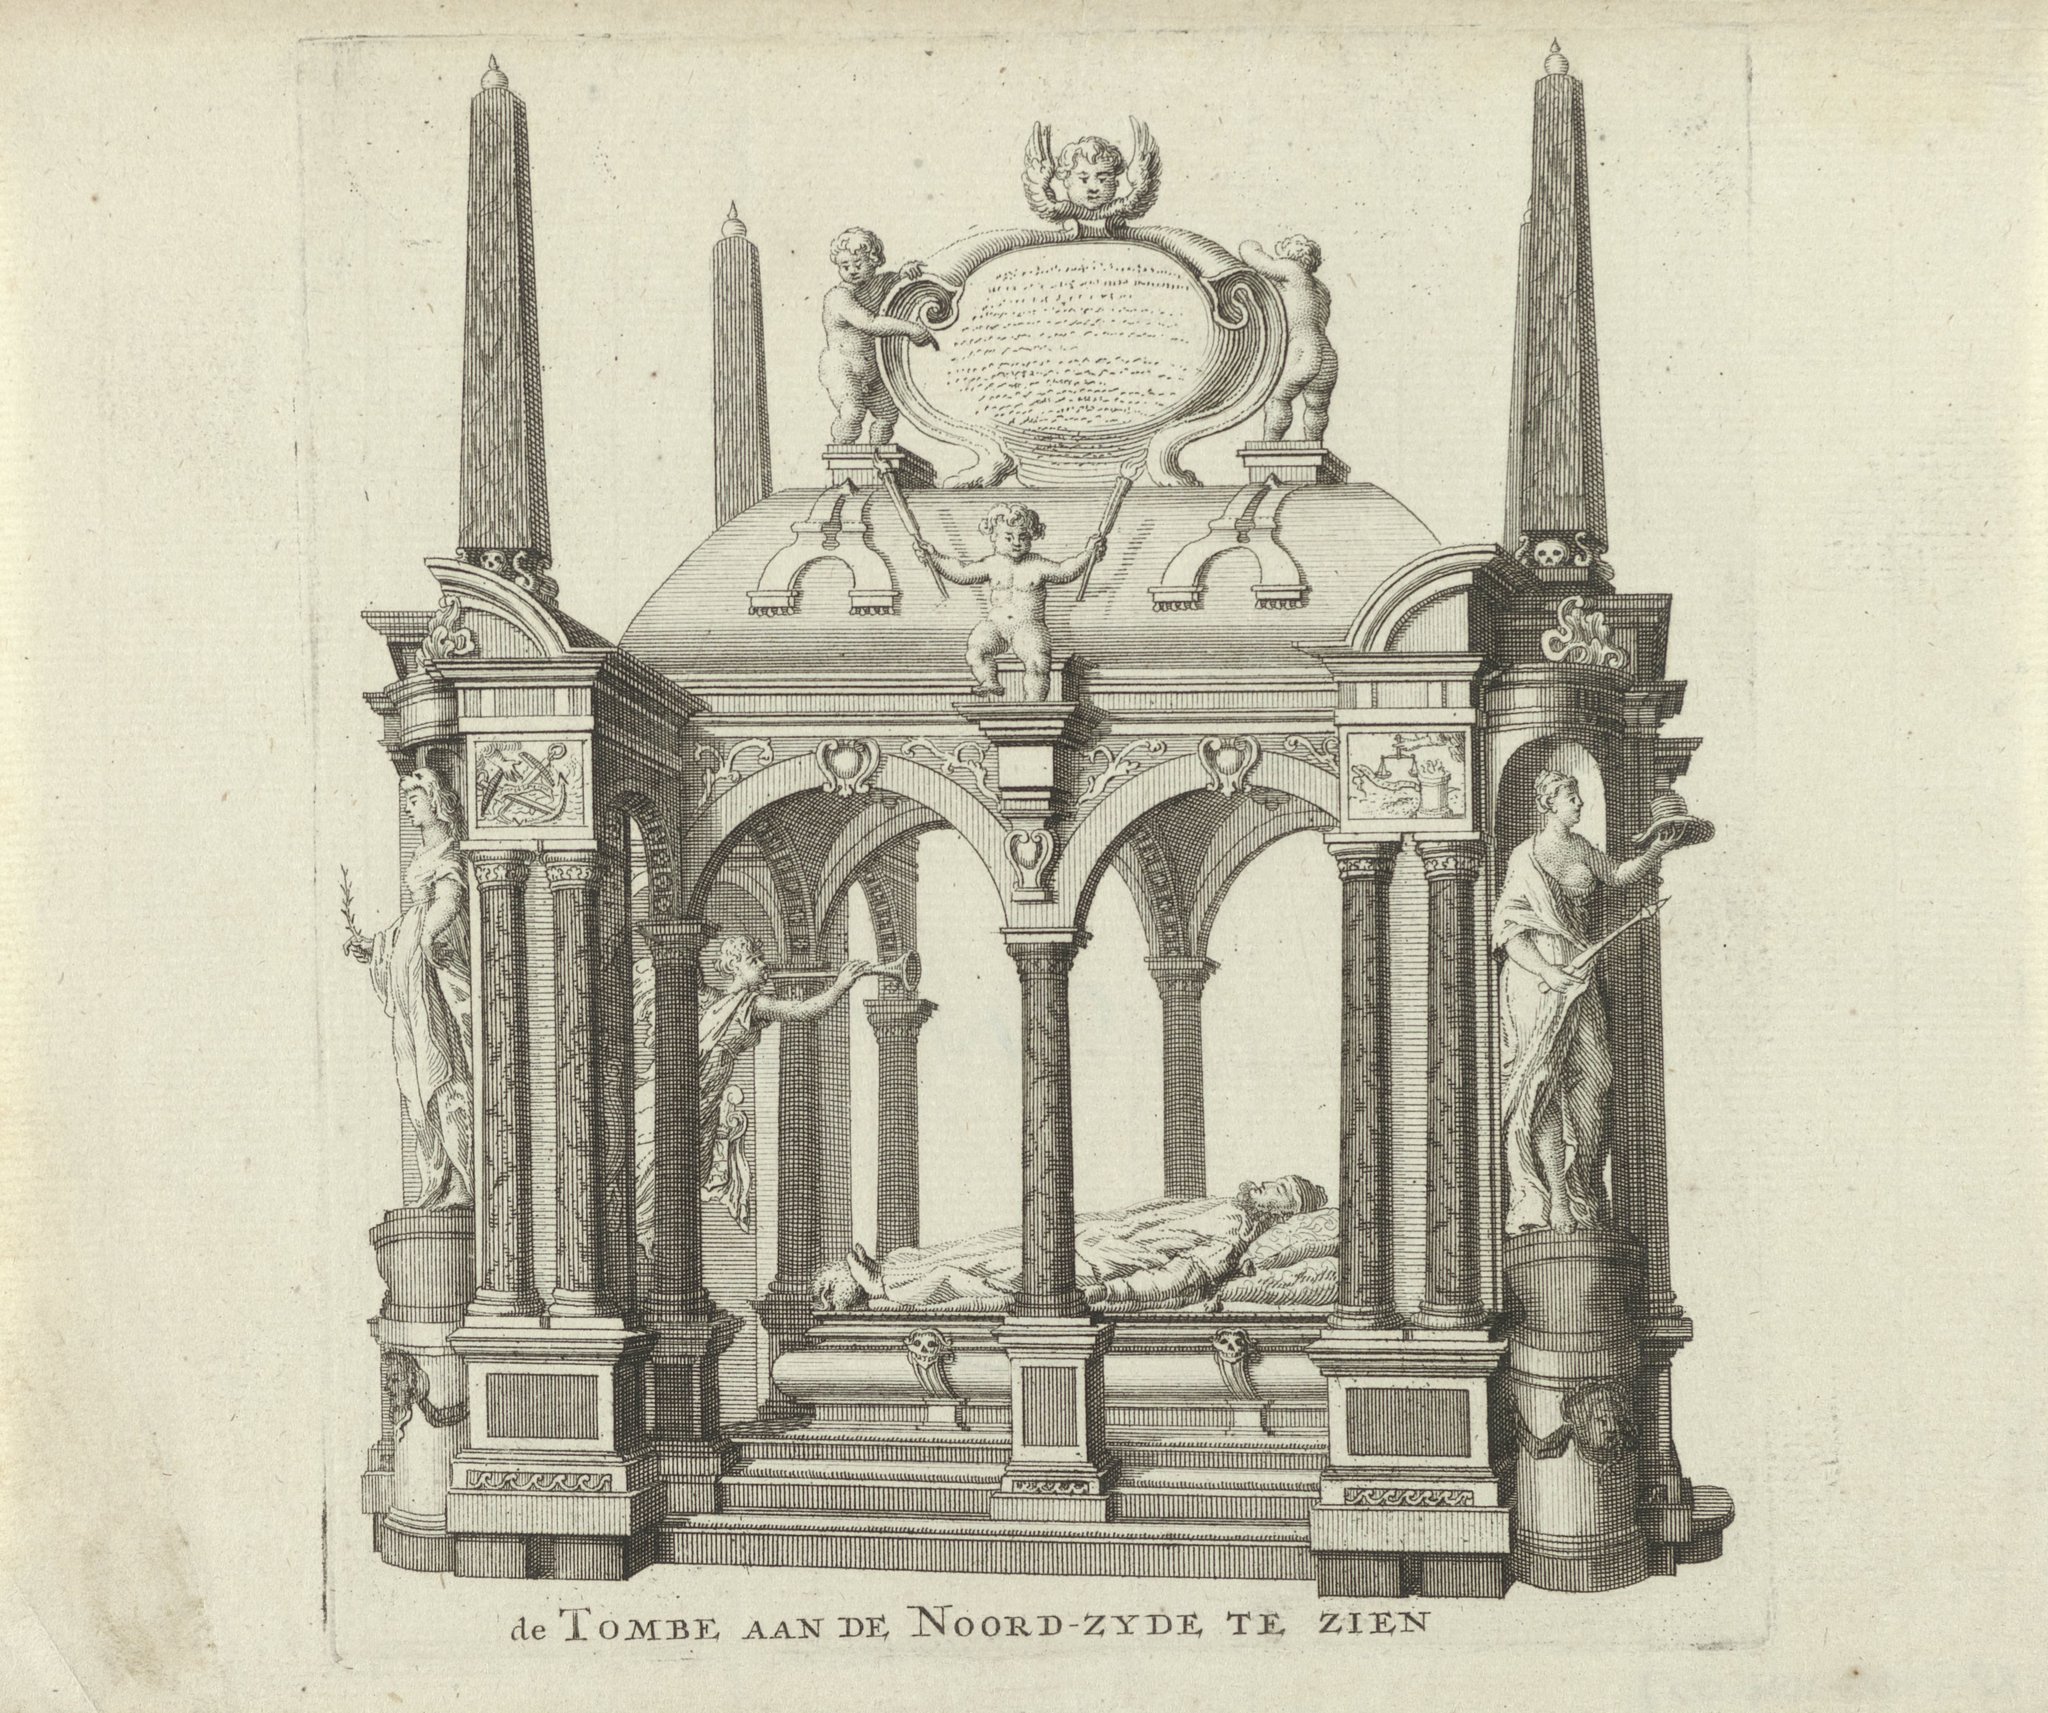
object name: print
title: de Tombe aan de Noord-zyde te zien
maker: Anonymous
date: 1700-1799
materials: paper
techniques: etching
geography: low countries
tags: delft, william i (prince of orange), historical persons, interior of church, grave-building, monumental tomb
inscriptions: collector's mark: Lugt 2228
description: De hier vermelde titel verwijst naar de hoogst verkregen titel van de geportretteerde, niet per se naar de titel die de geportretteerde op deze voorstelling draagt.